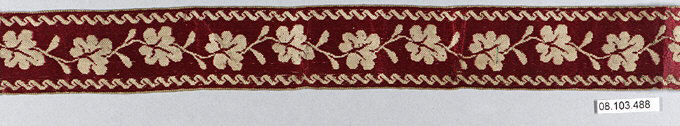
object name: galloon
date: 1801-1900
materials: silk